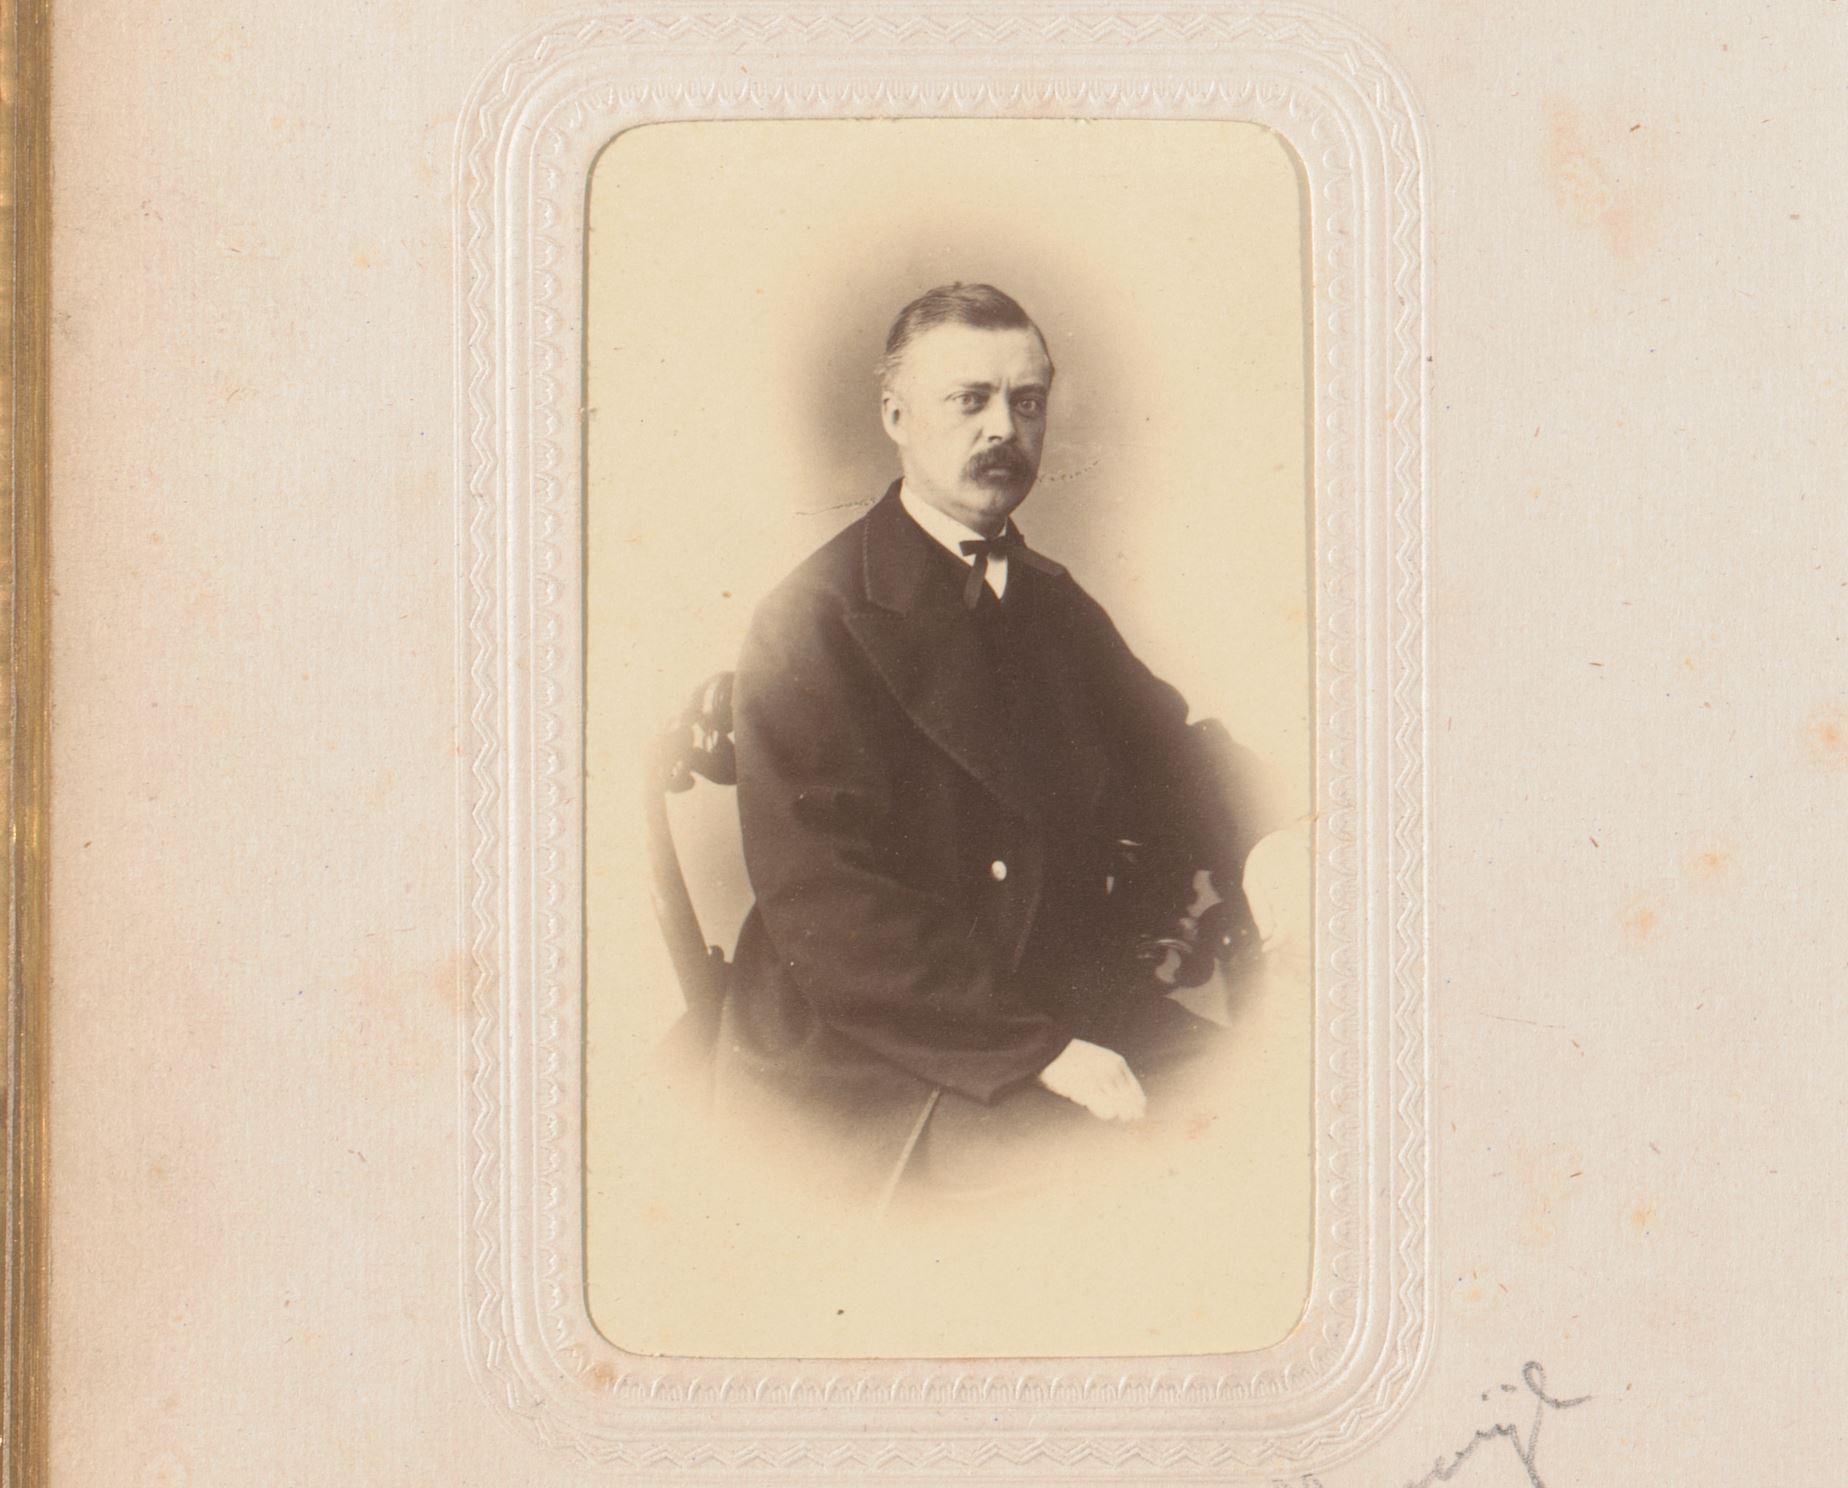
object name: photograph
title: Portret van een zittende man, aangeduid als A. Verschoor van Sleeswijk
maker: kornelis willem schorteldoek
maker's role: boekbinder, fotograaf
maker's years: 1800-1885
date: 1855-1885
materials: cardboard, photographic support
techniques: albumen print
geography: gorinchem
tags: sitting figure, historical persons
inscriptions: inscription: ‘SCHORTELDOEK/ PHOTOGRAAF/ GORINCHEM/ Groote Markt’, name: ‘A. Verschoor v. Sleeswijk’